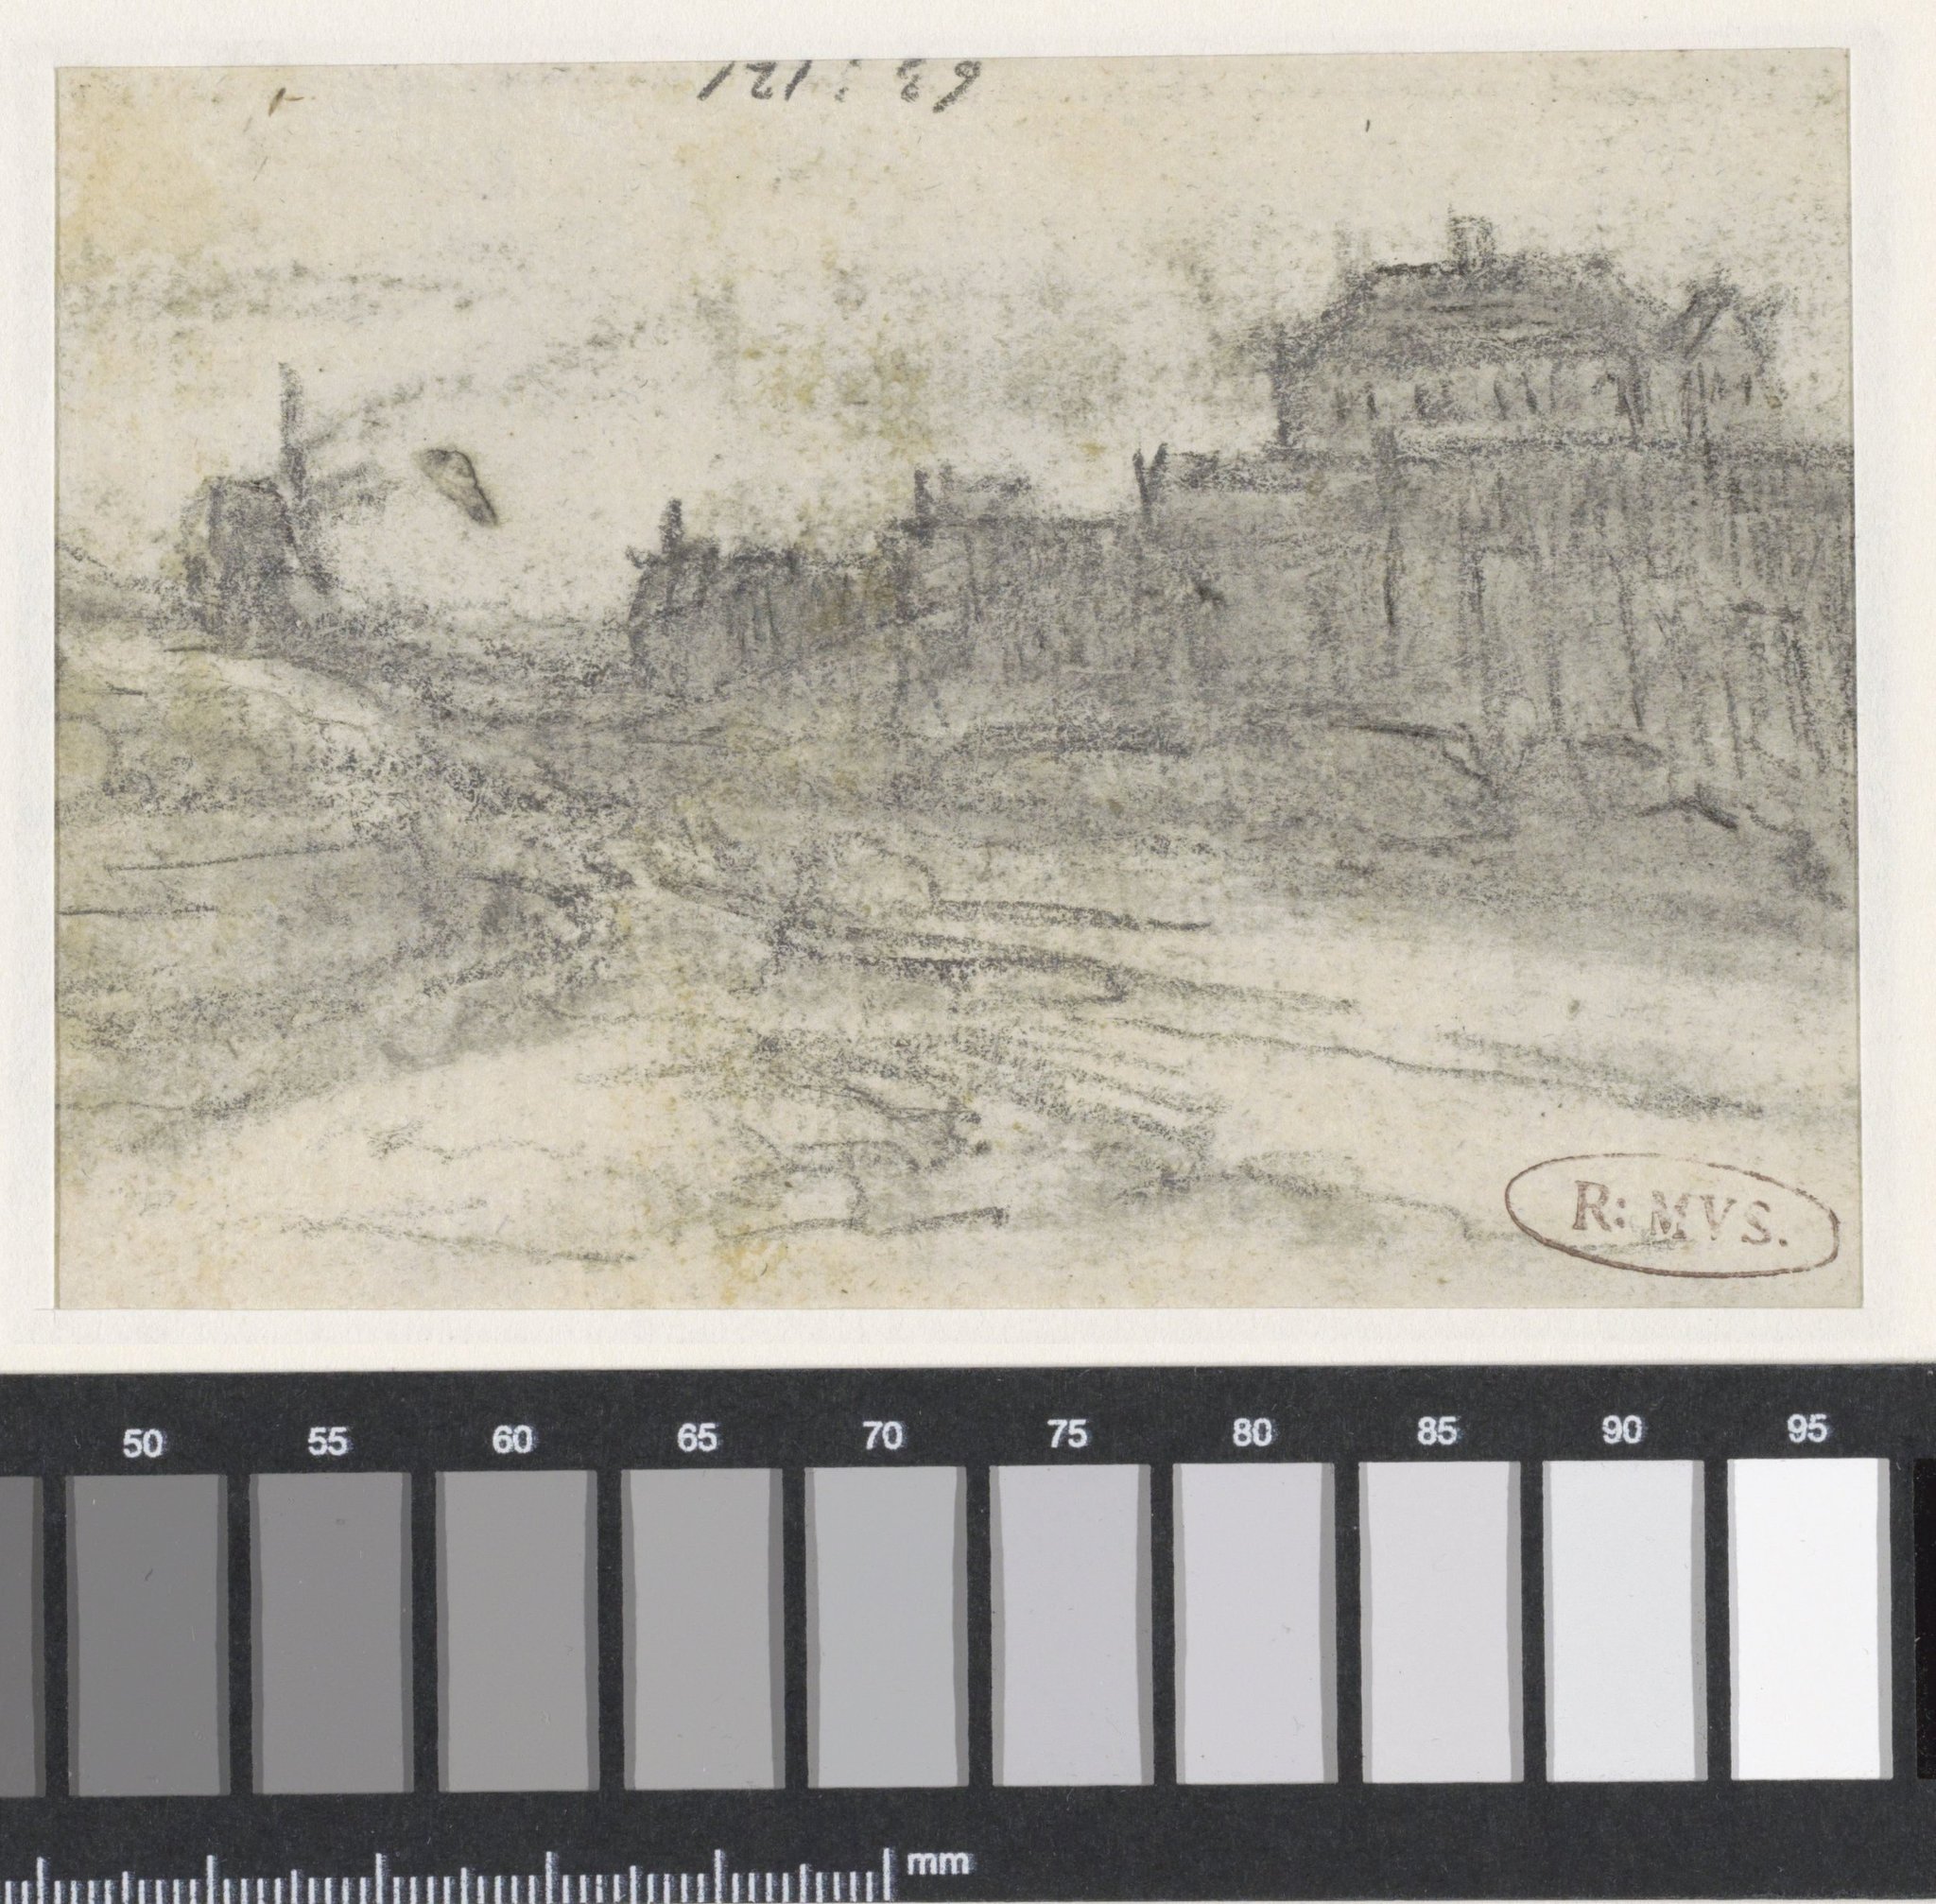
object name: drawing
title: Gezicht op de Butte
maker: georges michel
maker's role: draughtsman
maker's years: 1763-1843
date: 1773-1843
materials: chalk, paper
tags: outskirts of city (+ city (-scape) with figures, staffage)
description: Een van 120 tekeningen, afkomstig uit een 19e eeuws album met tekeningen van Georges Michel.